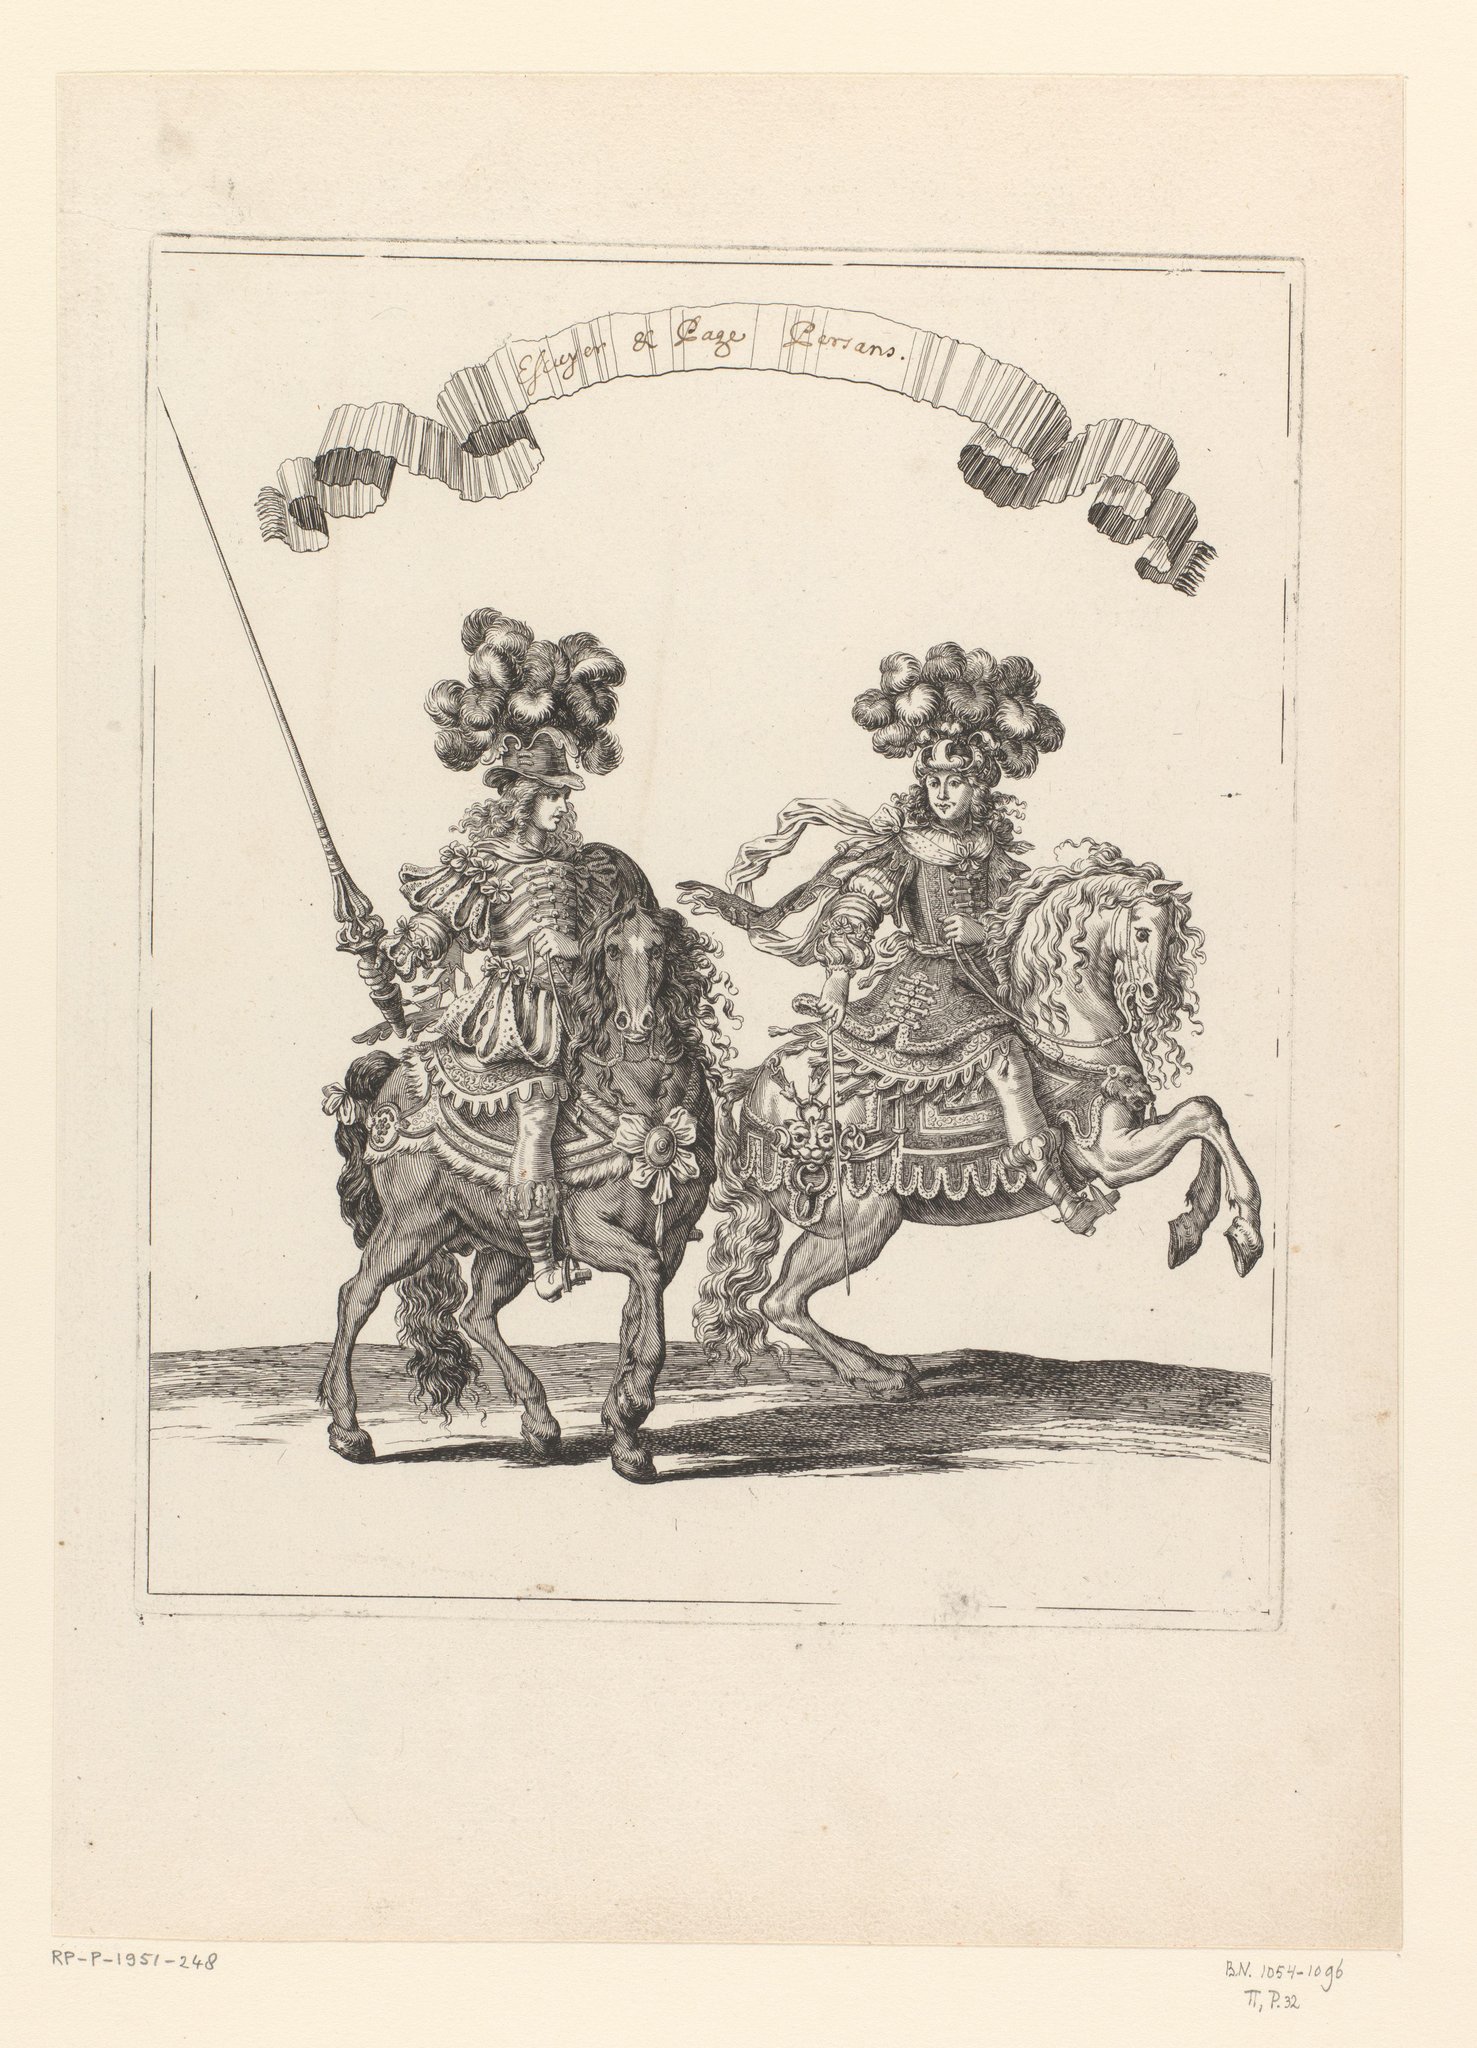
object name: print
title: Steekspeler en bediende te paard in Perzisch kostuum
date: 1670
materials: paper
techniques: etching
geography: paris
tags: tournament, joust, tilt, horse, festivities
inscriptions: collector's mark: Lugt 2228, inscription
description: Prent uit: Perrault, Charles. Courses de testes et de bague faites par le Roy et par les princes et seigneurs de sa cour en l'année M.DC.LXII. Parijs: Imprimerie Royale, 1670. De prenten illustreren de door Lodewijk XIV georganiseerde festiviteiten in juni 1662 te Tuileries, zoals steekspelen met figuren in verschillende kostuums.